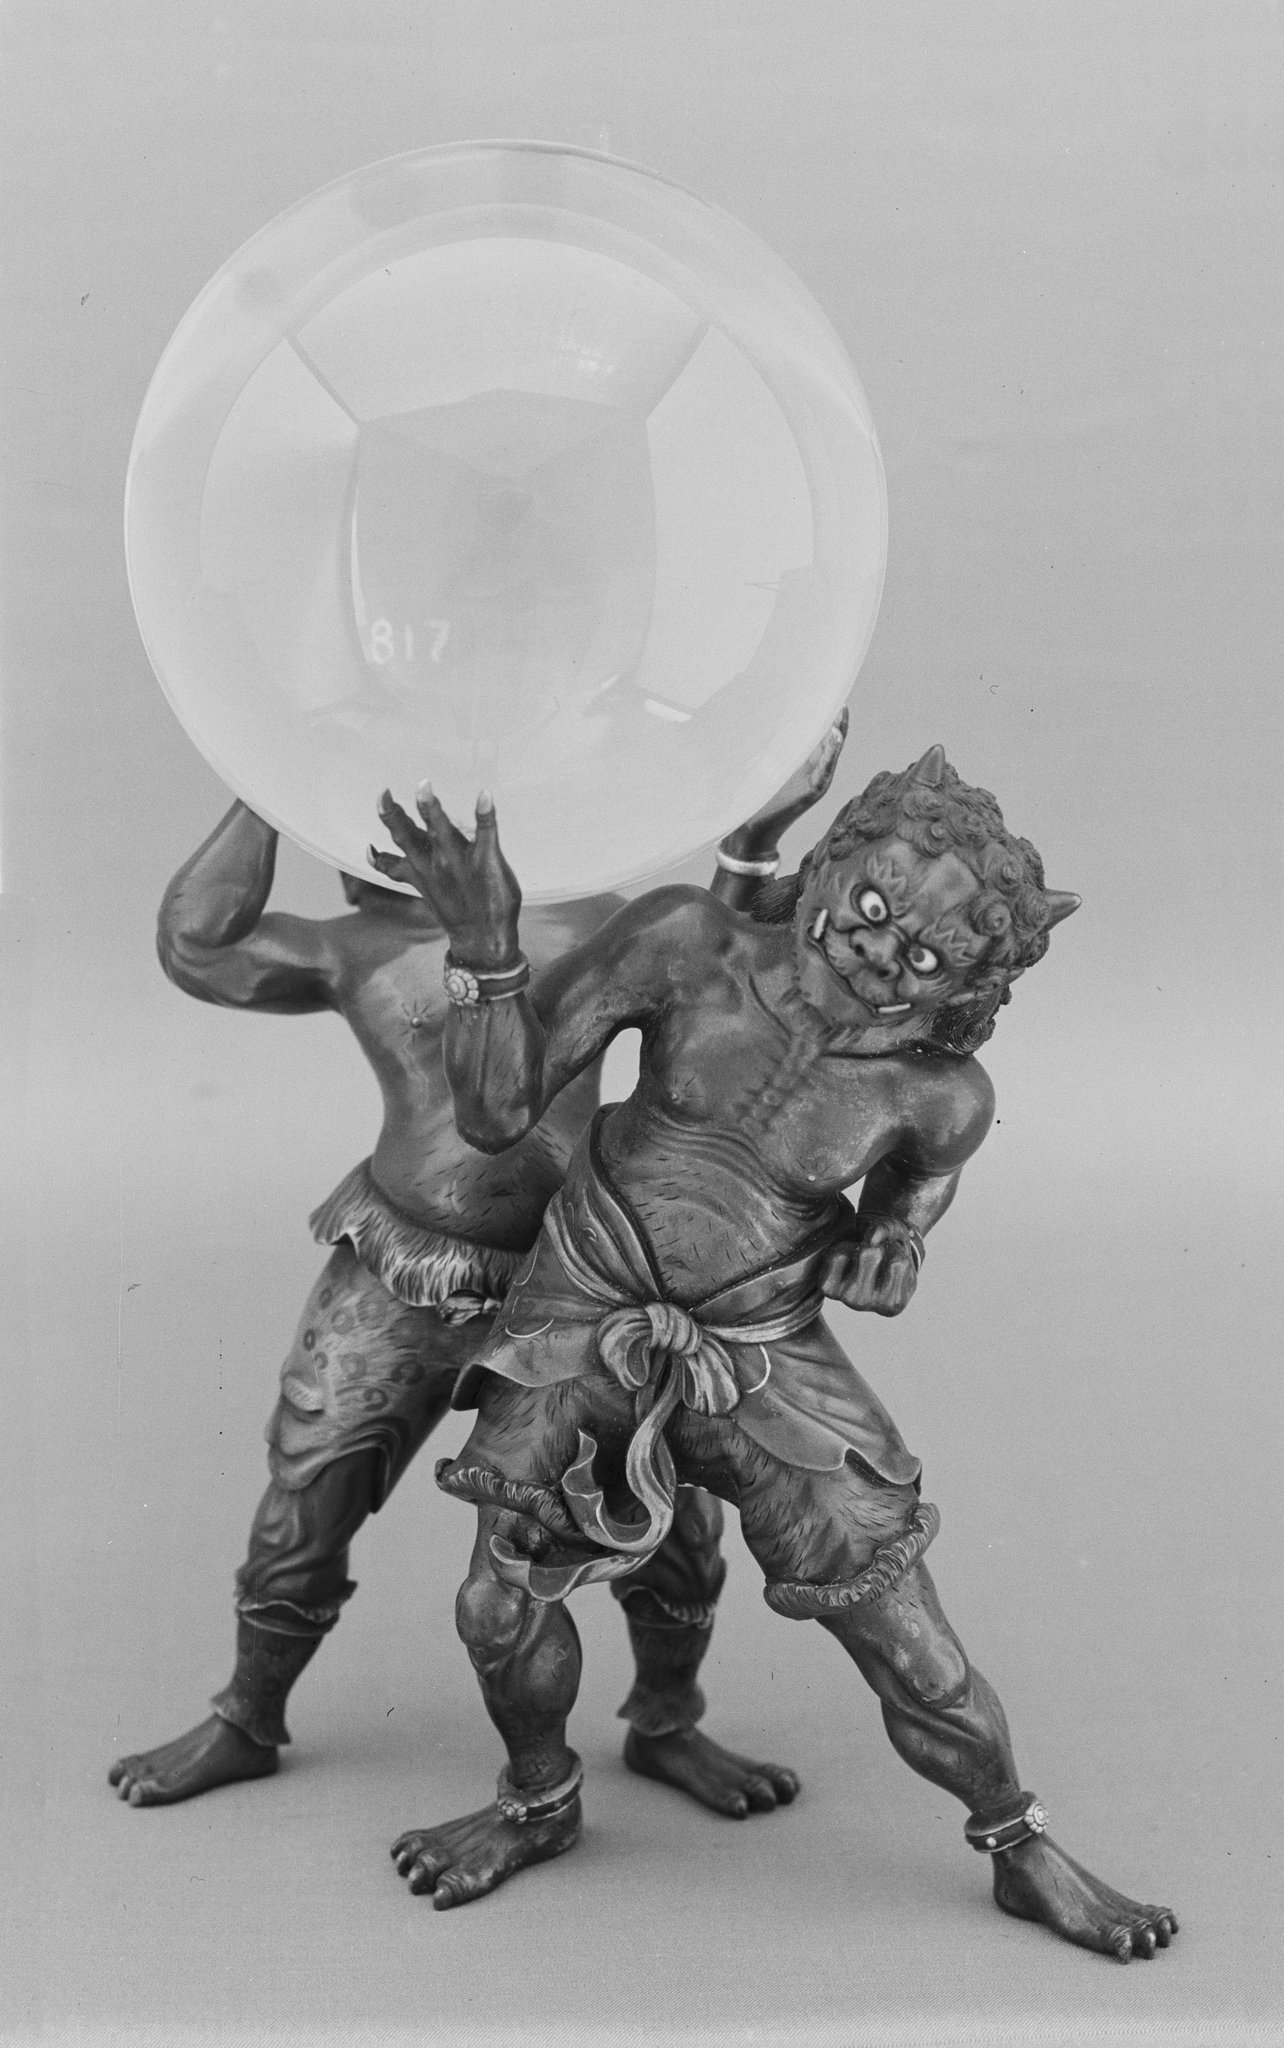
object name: crystal ball on stand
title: Crystal Ball on a Bronze Stand composed of Two Demons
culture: chinese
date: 1701-1800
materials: bronze, quartz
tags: demons